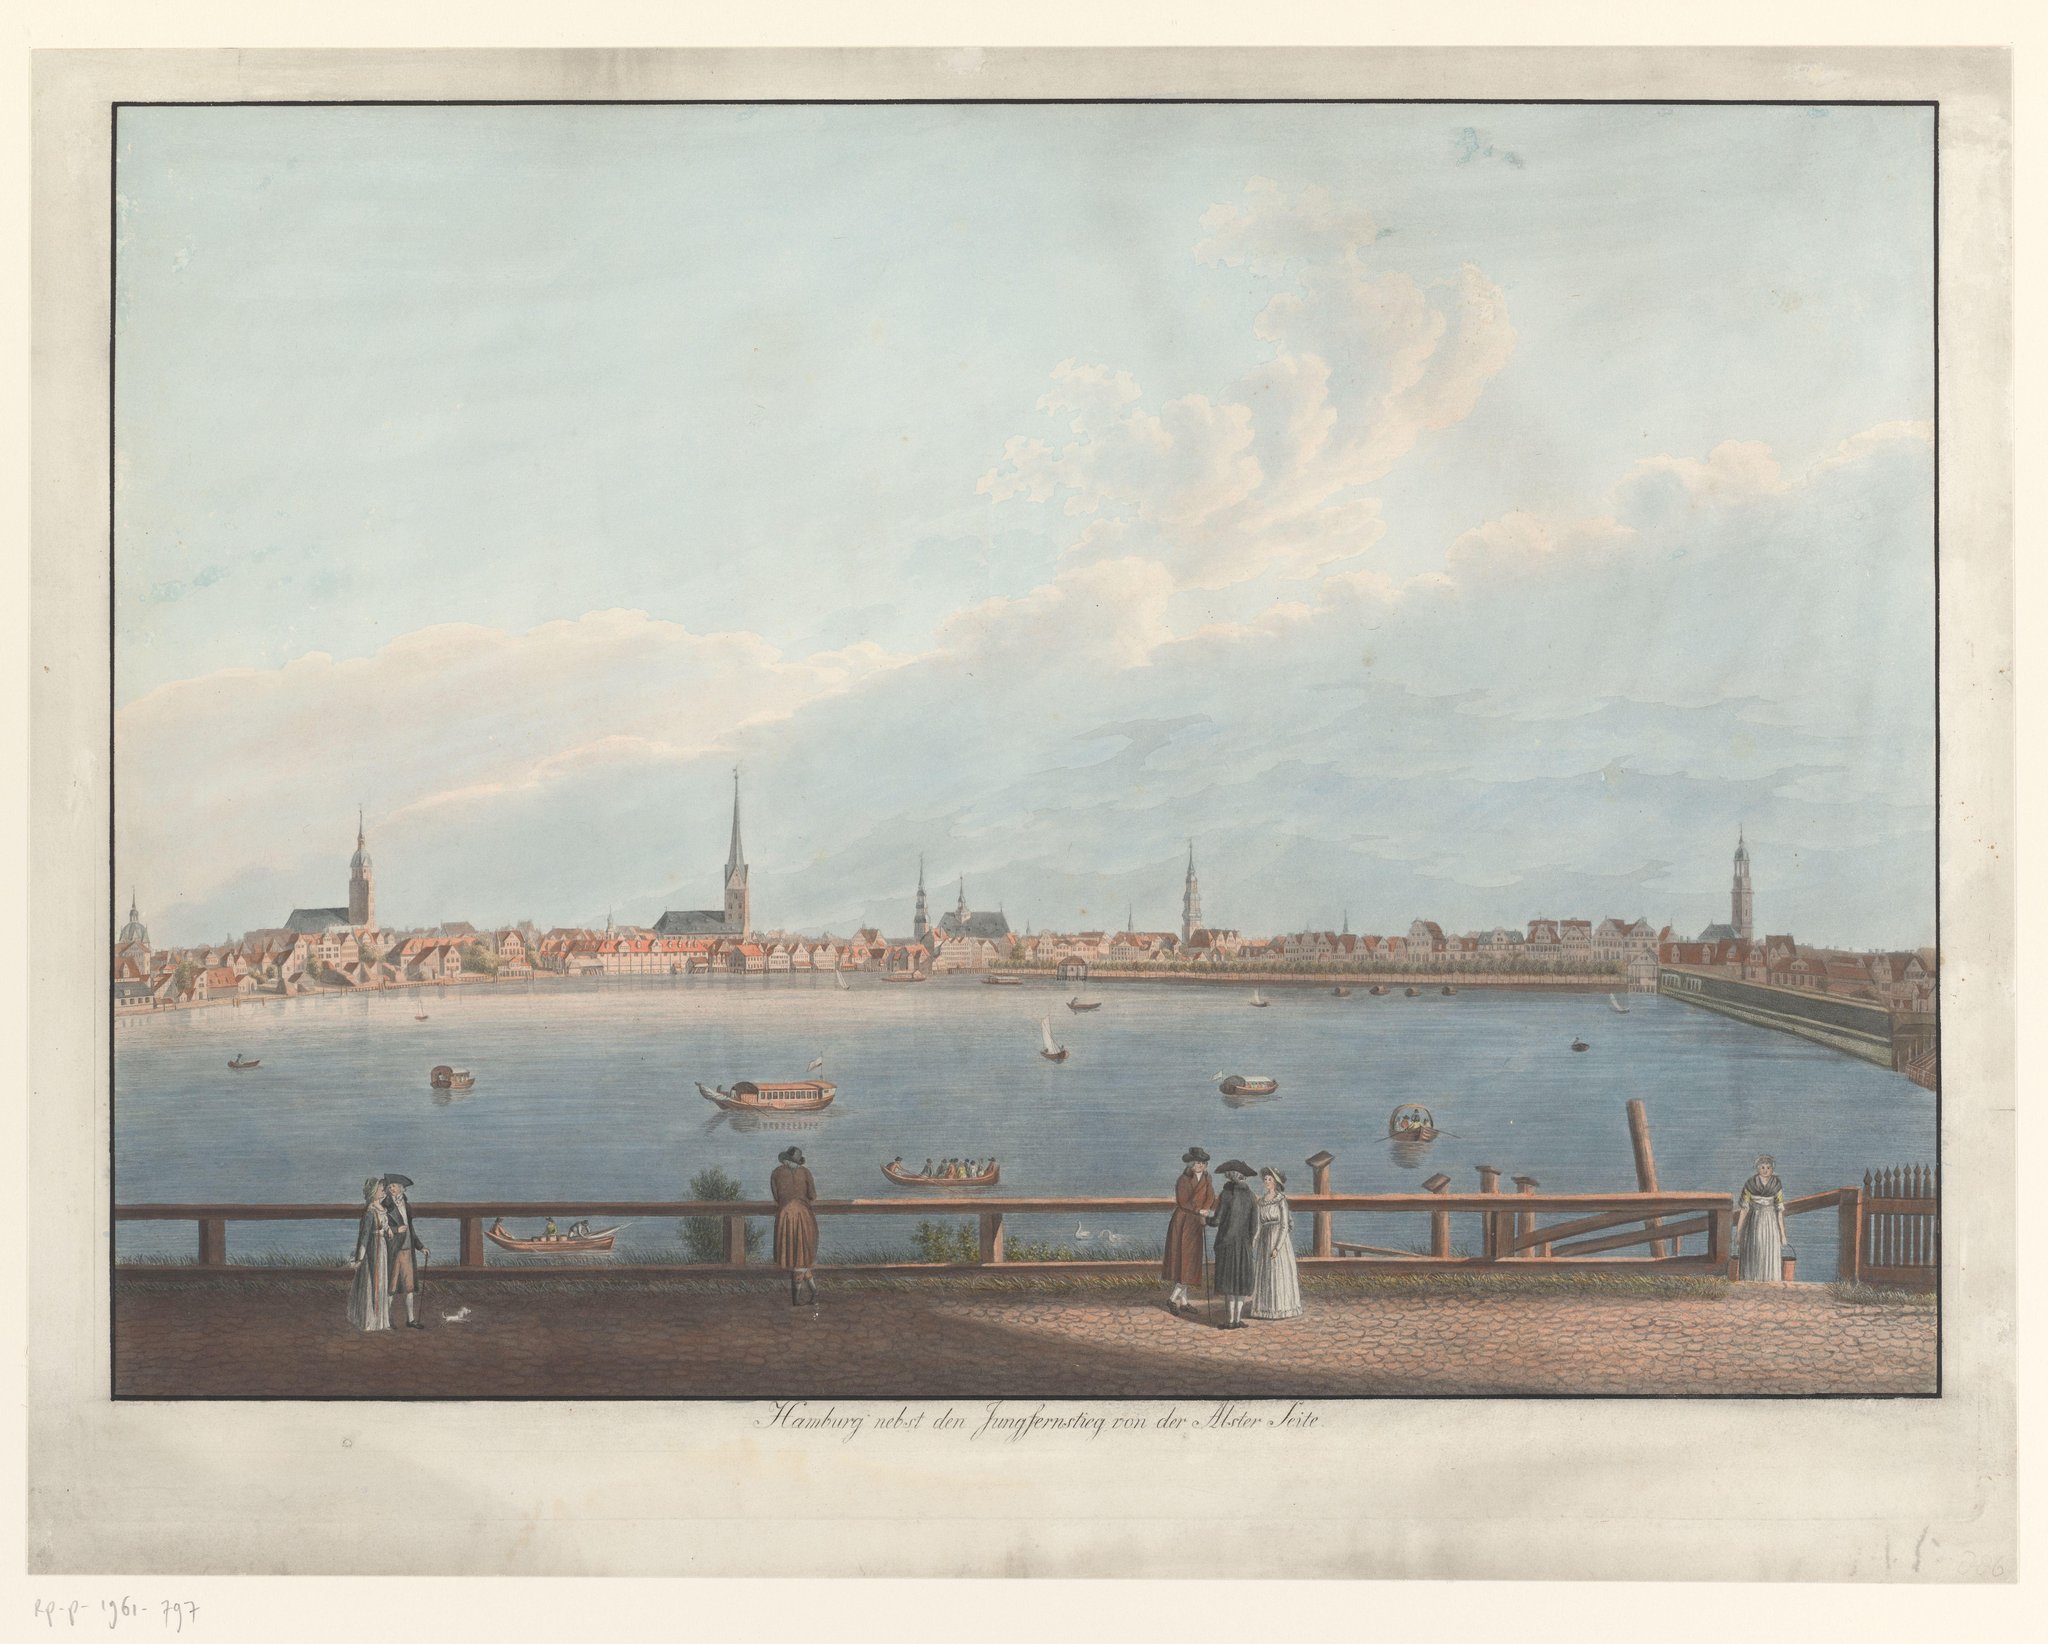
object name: print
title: Hamburg von der Alster-Seite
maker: leopold beyer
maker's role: print maker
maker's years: 1789-1877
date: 1794-1870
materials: paper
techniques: aquatint, etching, hand coloring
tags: city-view in general; 'veduta'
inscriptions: collector's mark: Lugt 2228